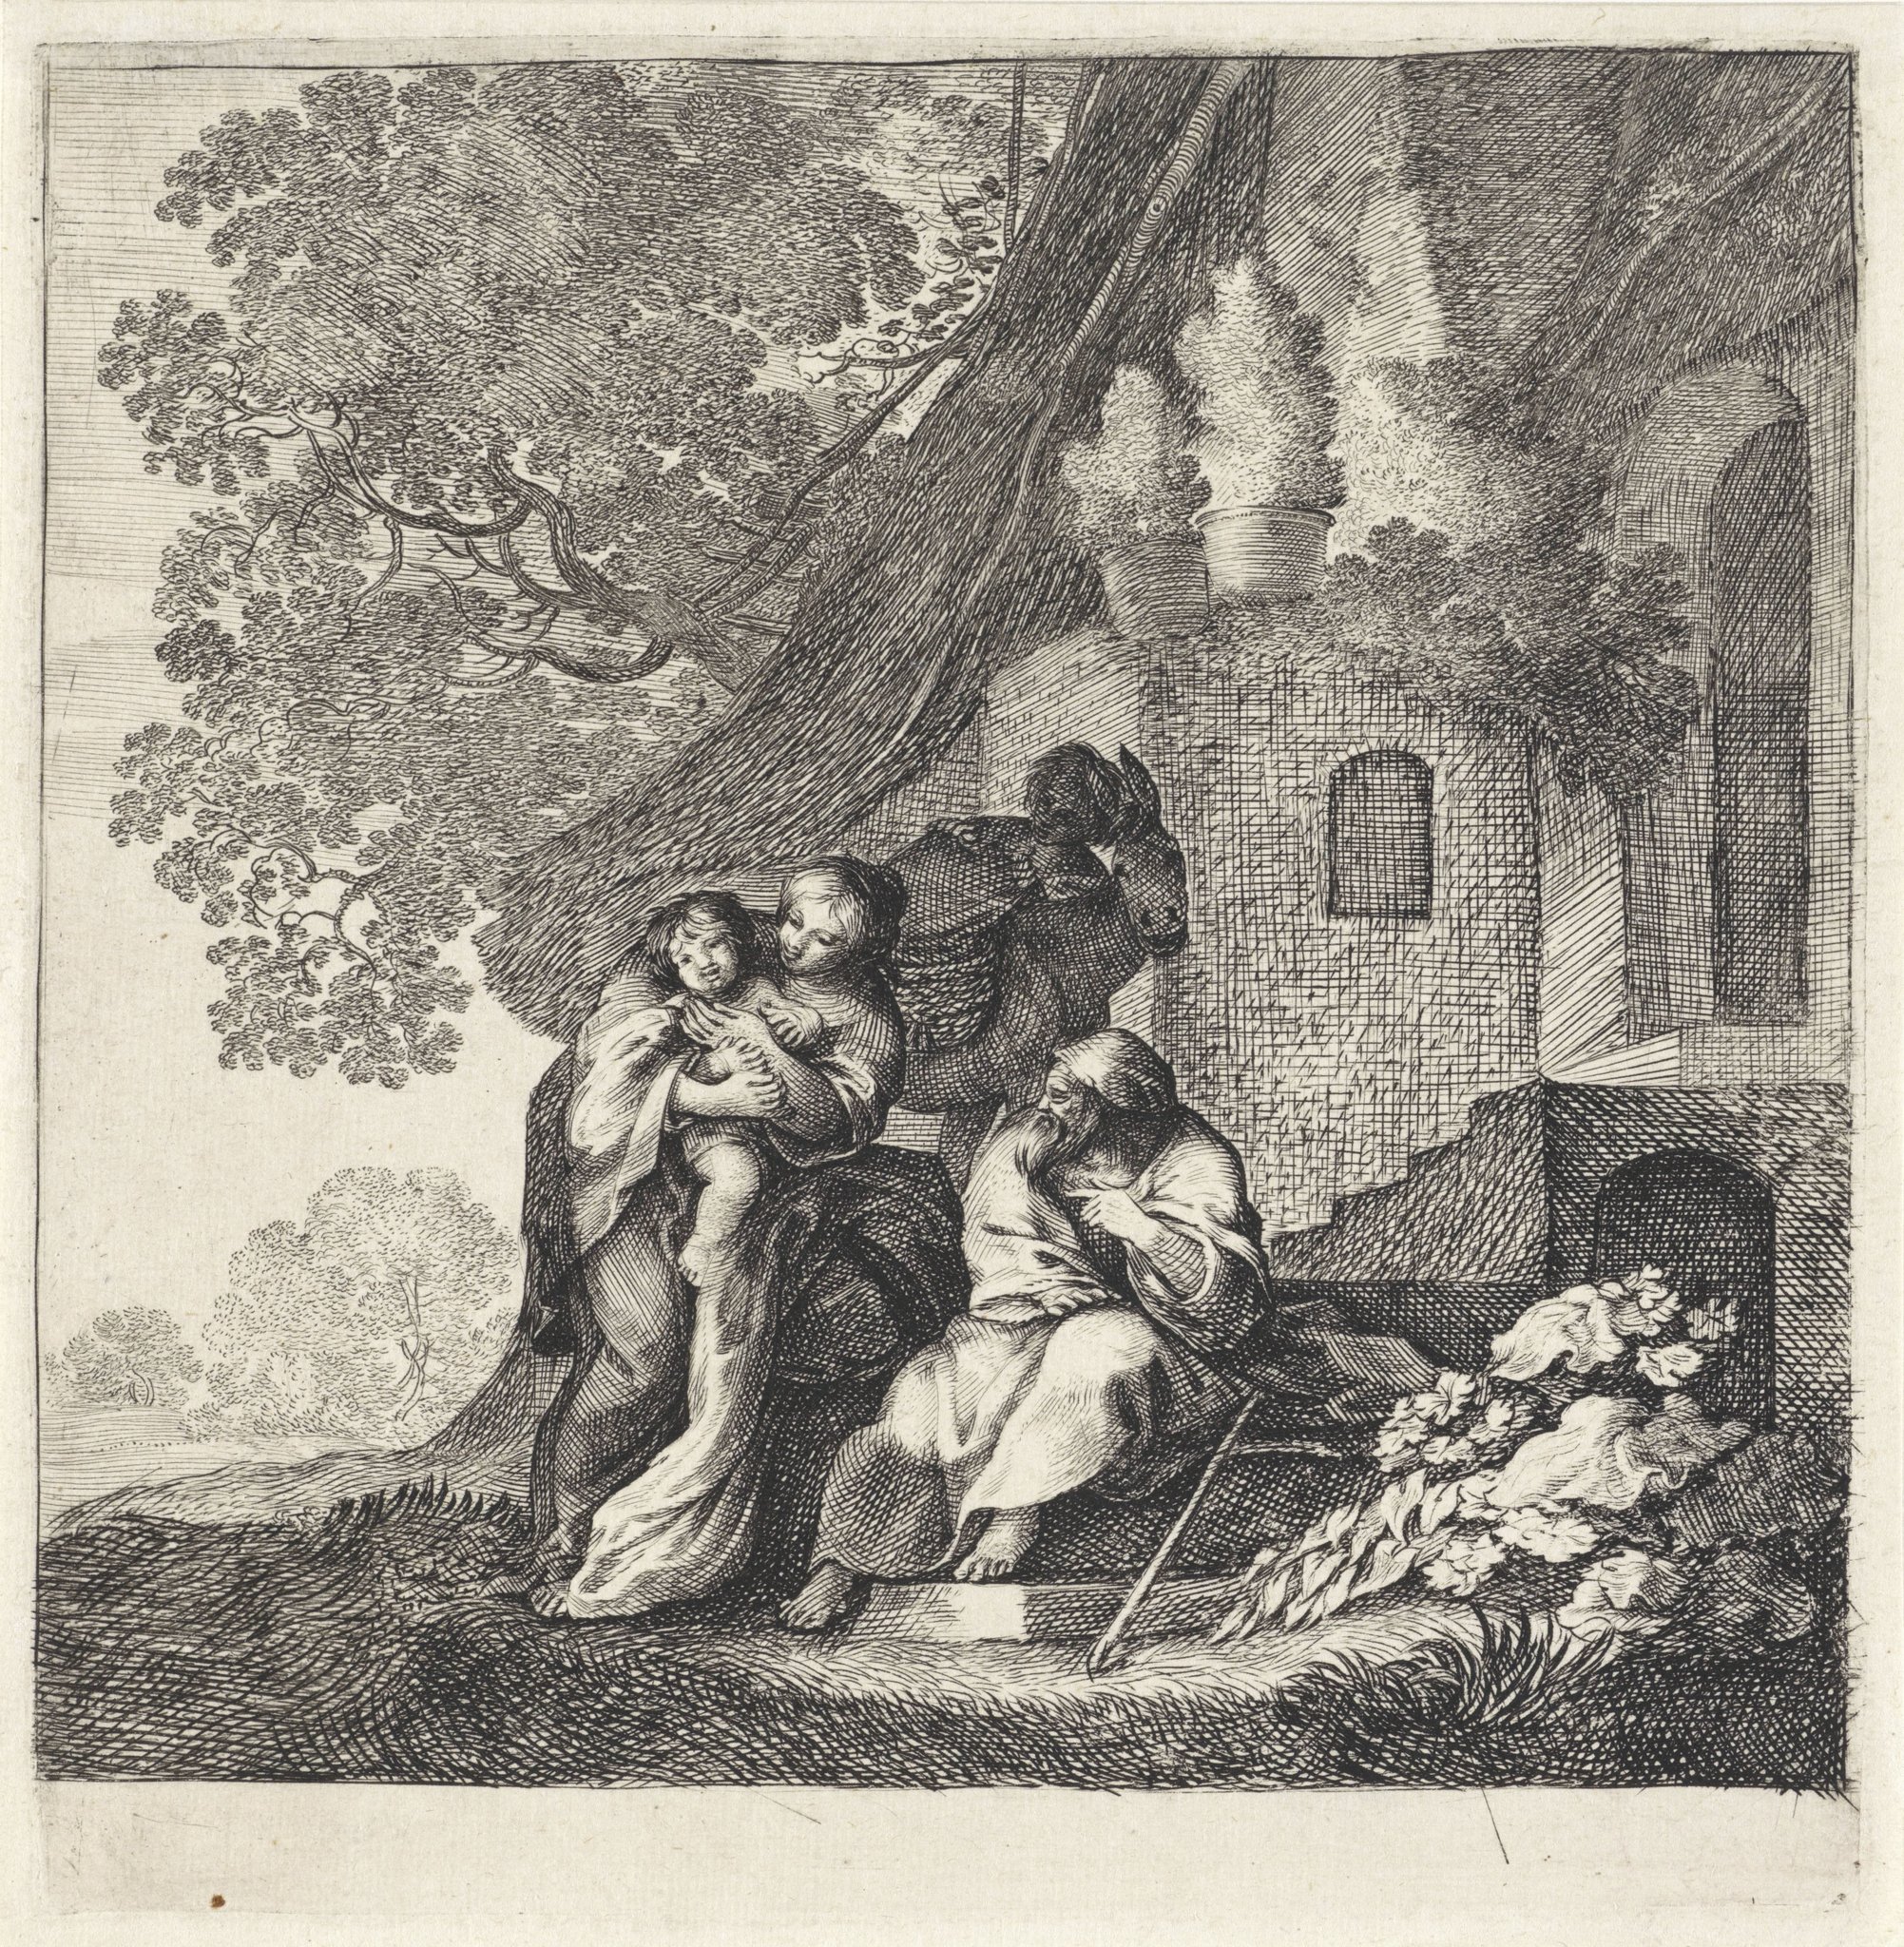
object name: print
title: Terugkeer van de Heilige Familie uit Egypte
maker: moyses van wtenbrouck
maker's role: painter, print maker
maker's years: 1590-1647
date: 1600-1647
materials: paper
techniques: engraving, etching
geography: the hague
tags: rest on the return of the holy family to israel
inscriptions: collector's mark: Lugt 240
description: Maria staat voor een rietgedekt huis met het Christuskind op haar arm. Naast haar zit Jozef op een stenen trap. Achter hen staat een jongen met een bepakte ezel.